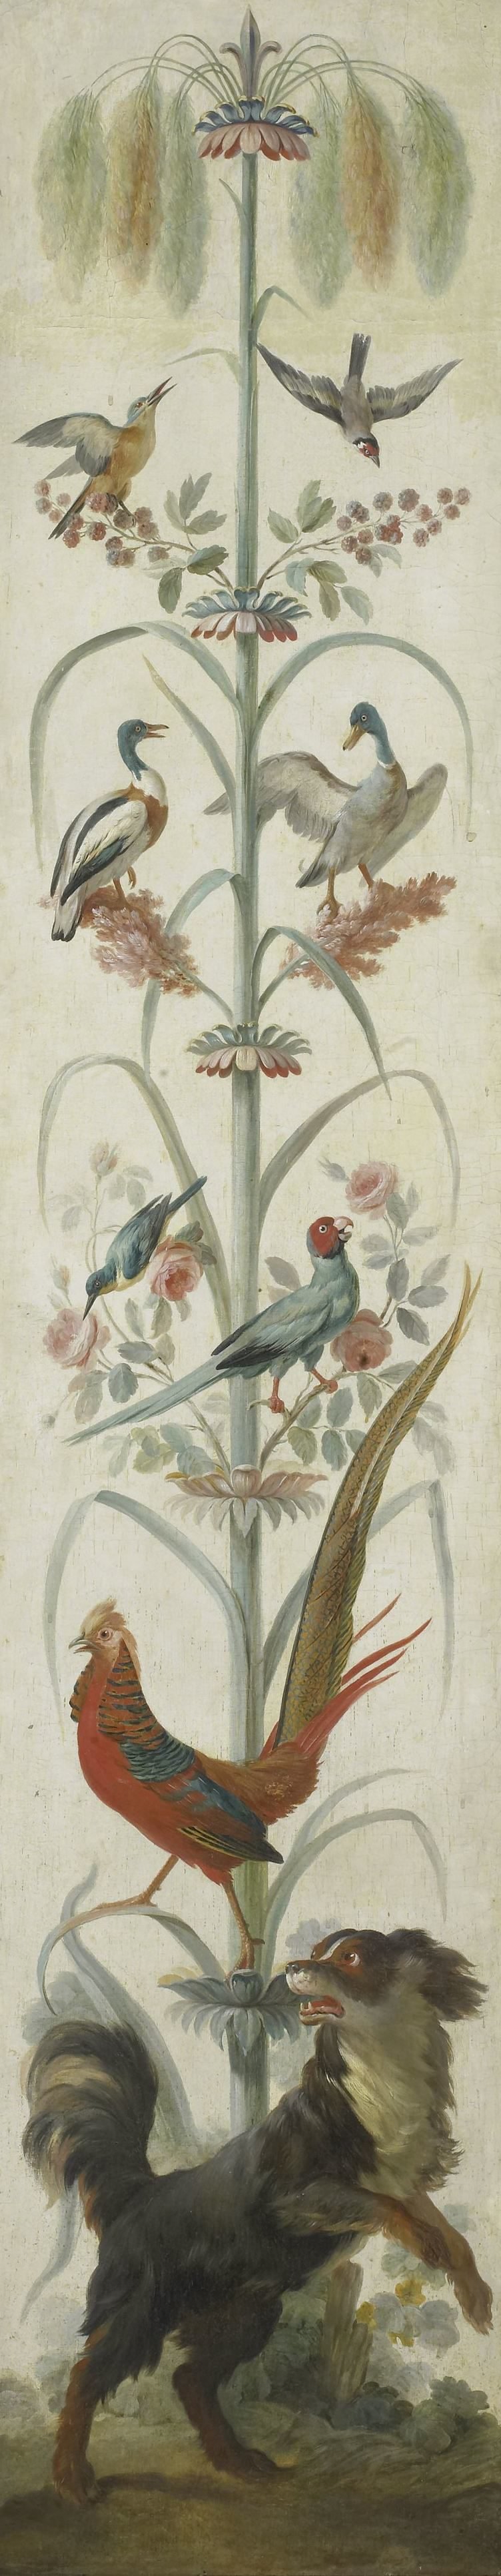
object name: painting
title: Decorative Depiction with Plants and Animals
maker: Anonymous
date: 1760-1799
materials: canvas, oil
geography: france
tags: birds, walker and runner birds: pheasant, dog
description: French school, c. 1775. Four decorative paintings with plants and animals.